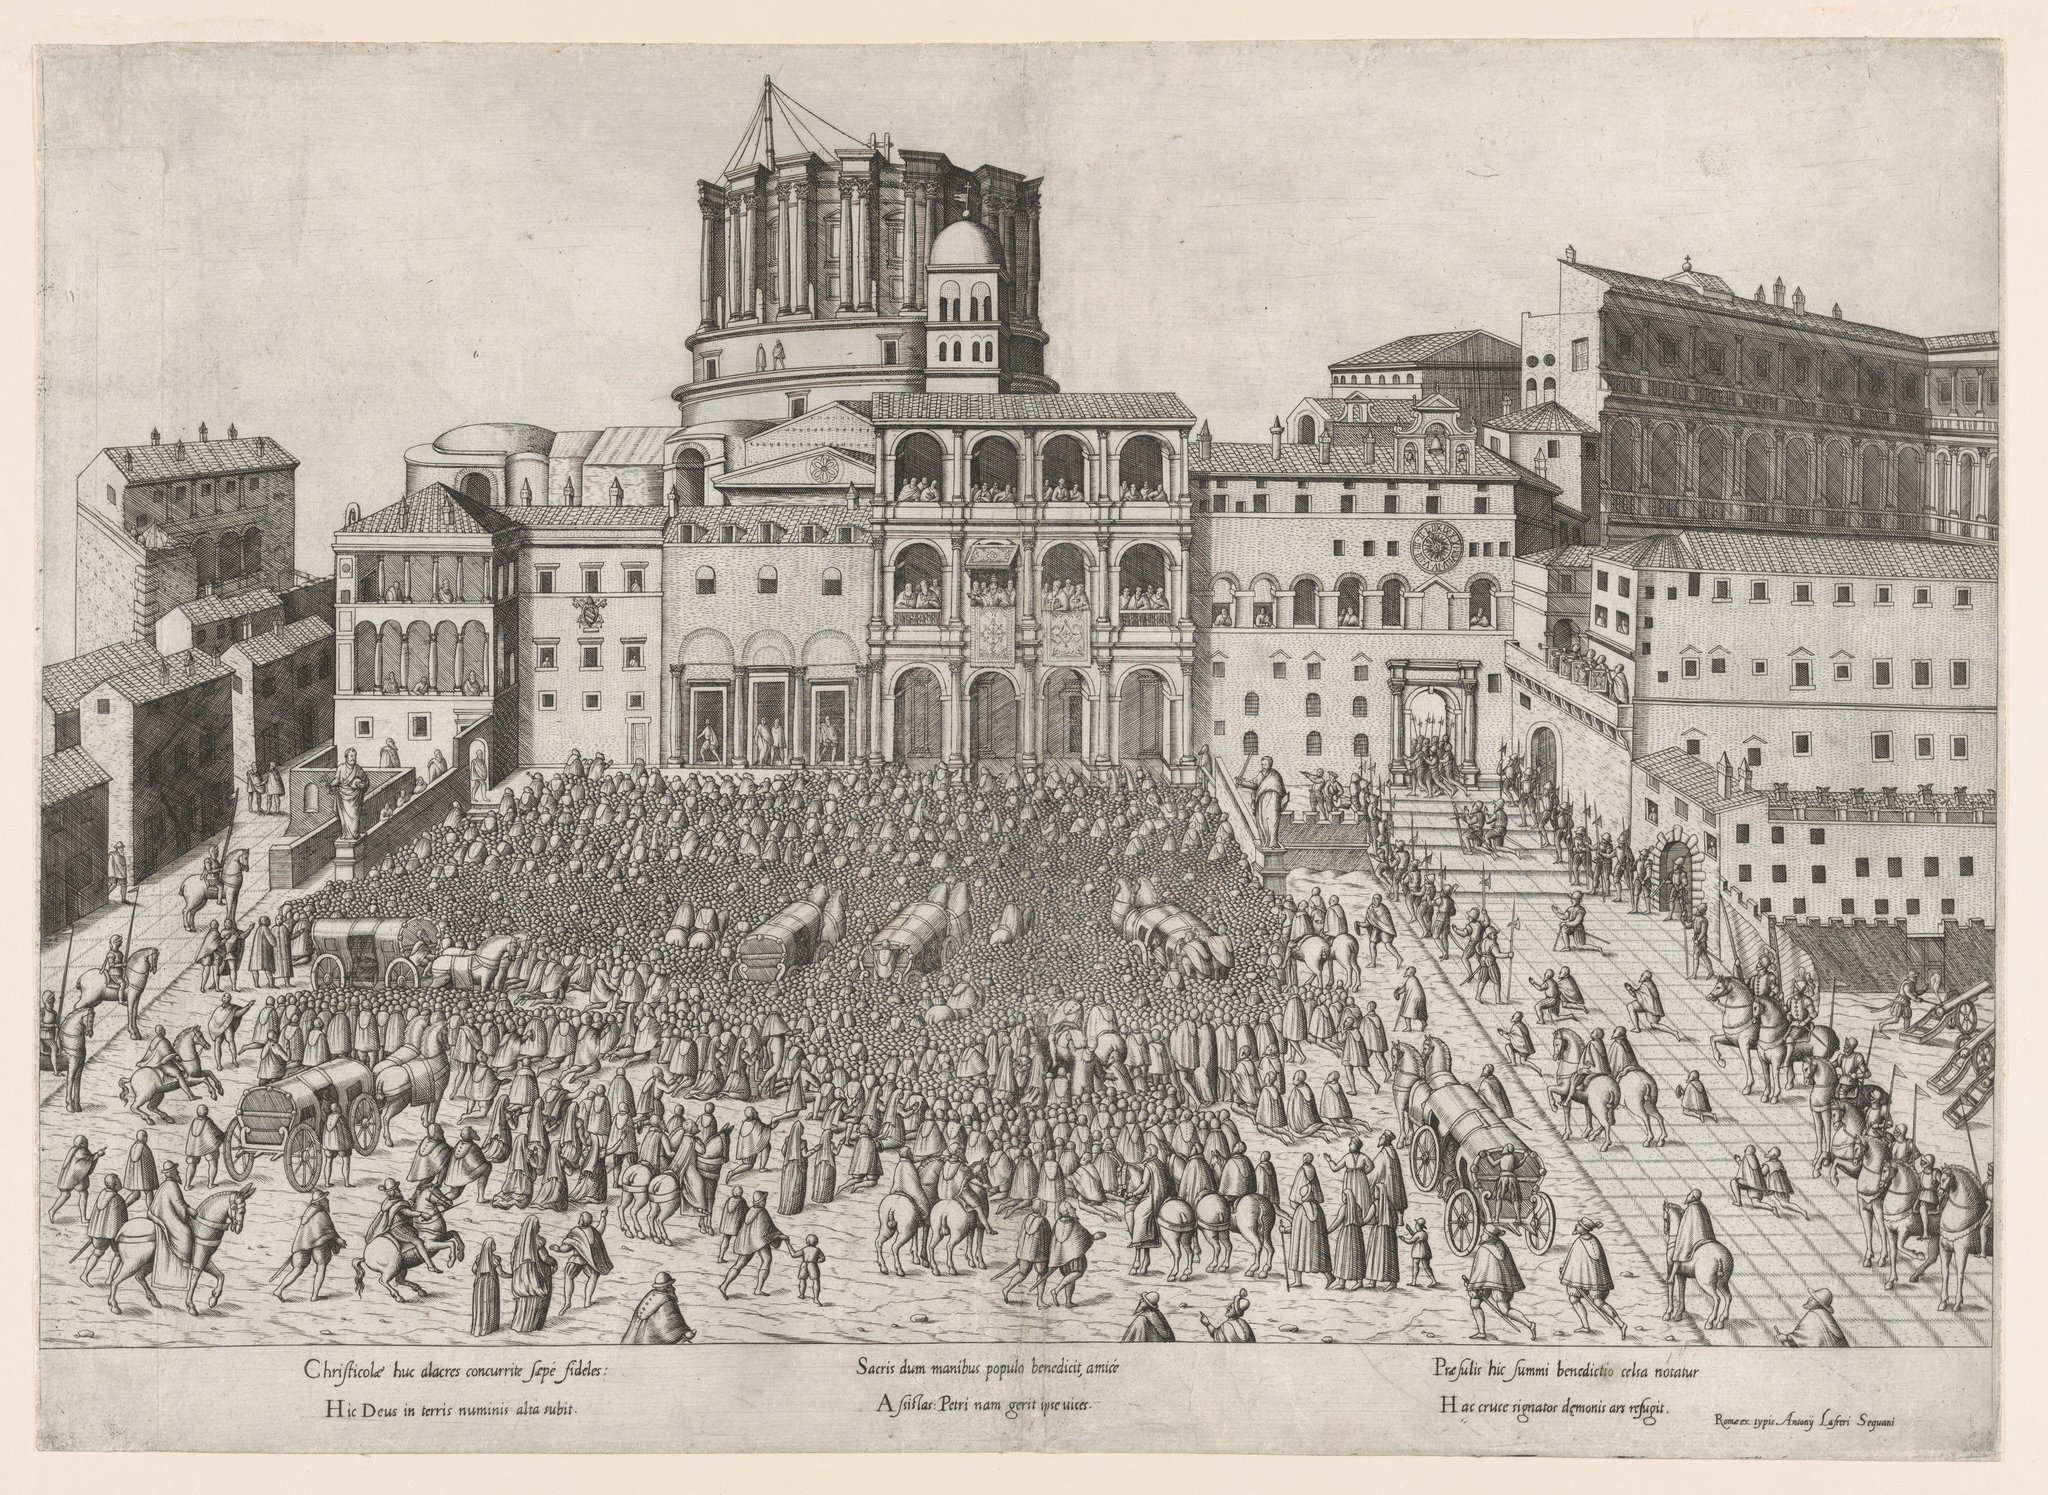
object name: print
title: Papal Benediction, from "Speculum Romanae Magnificentiae"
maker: Anonymous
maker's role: artist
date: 1501-1600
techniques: engraving, etching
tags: buildings,men,women,horses,crowd,rome